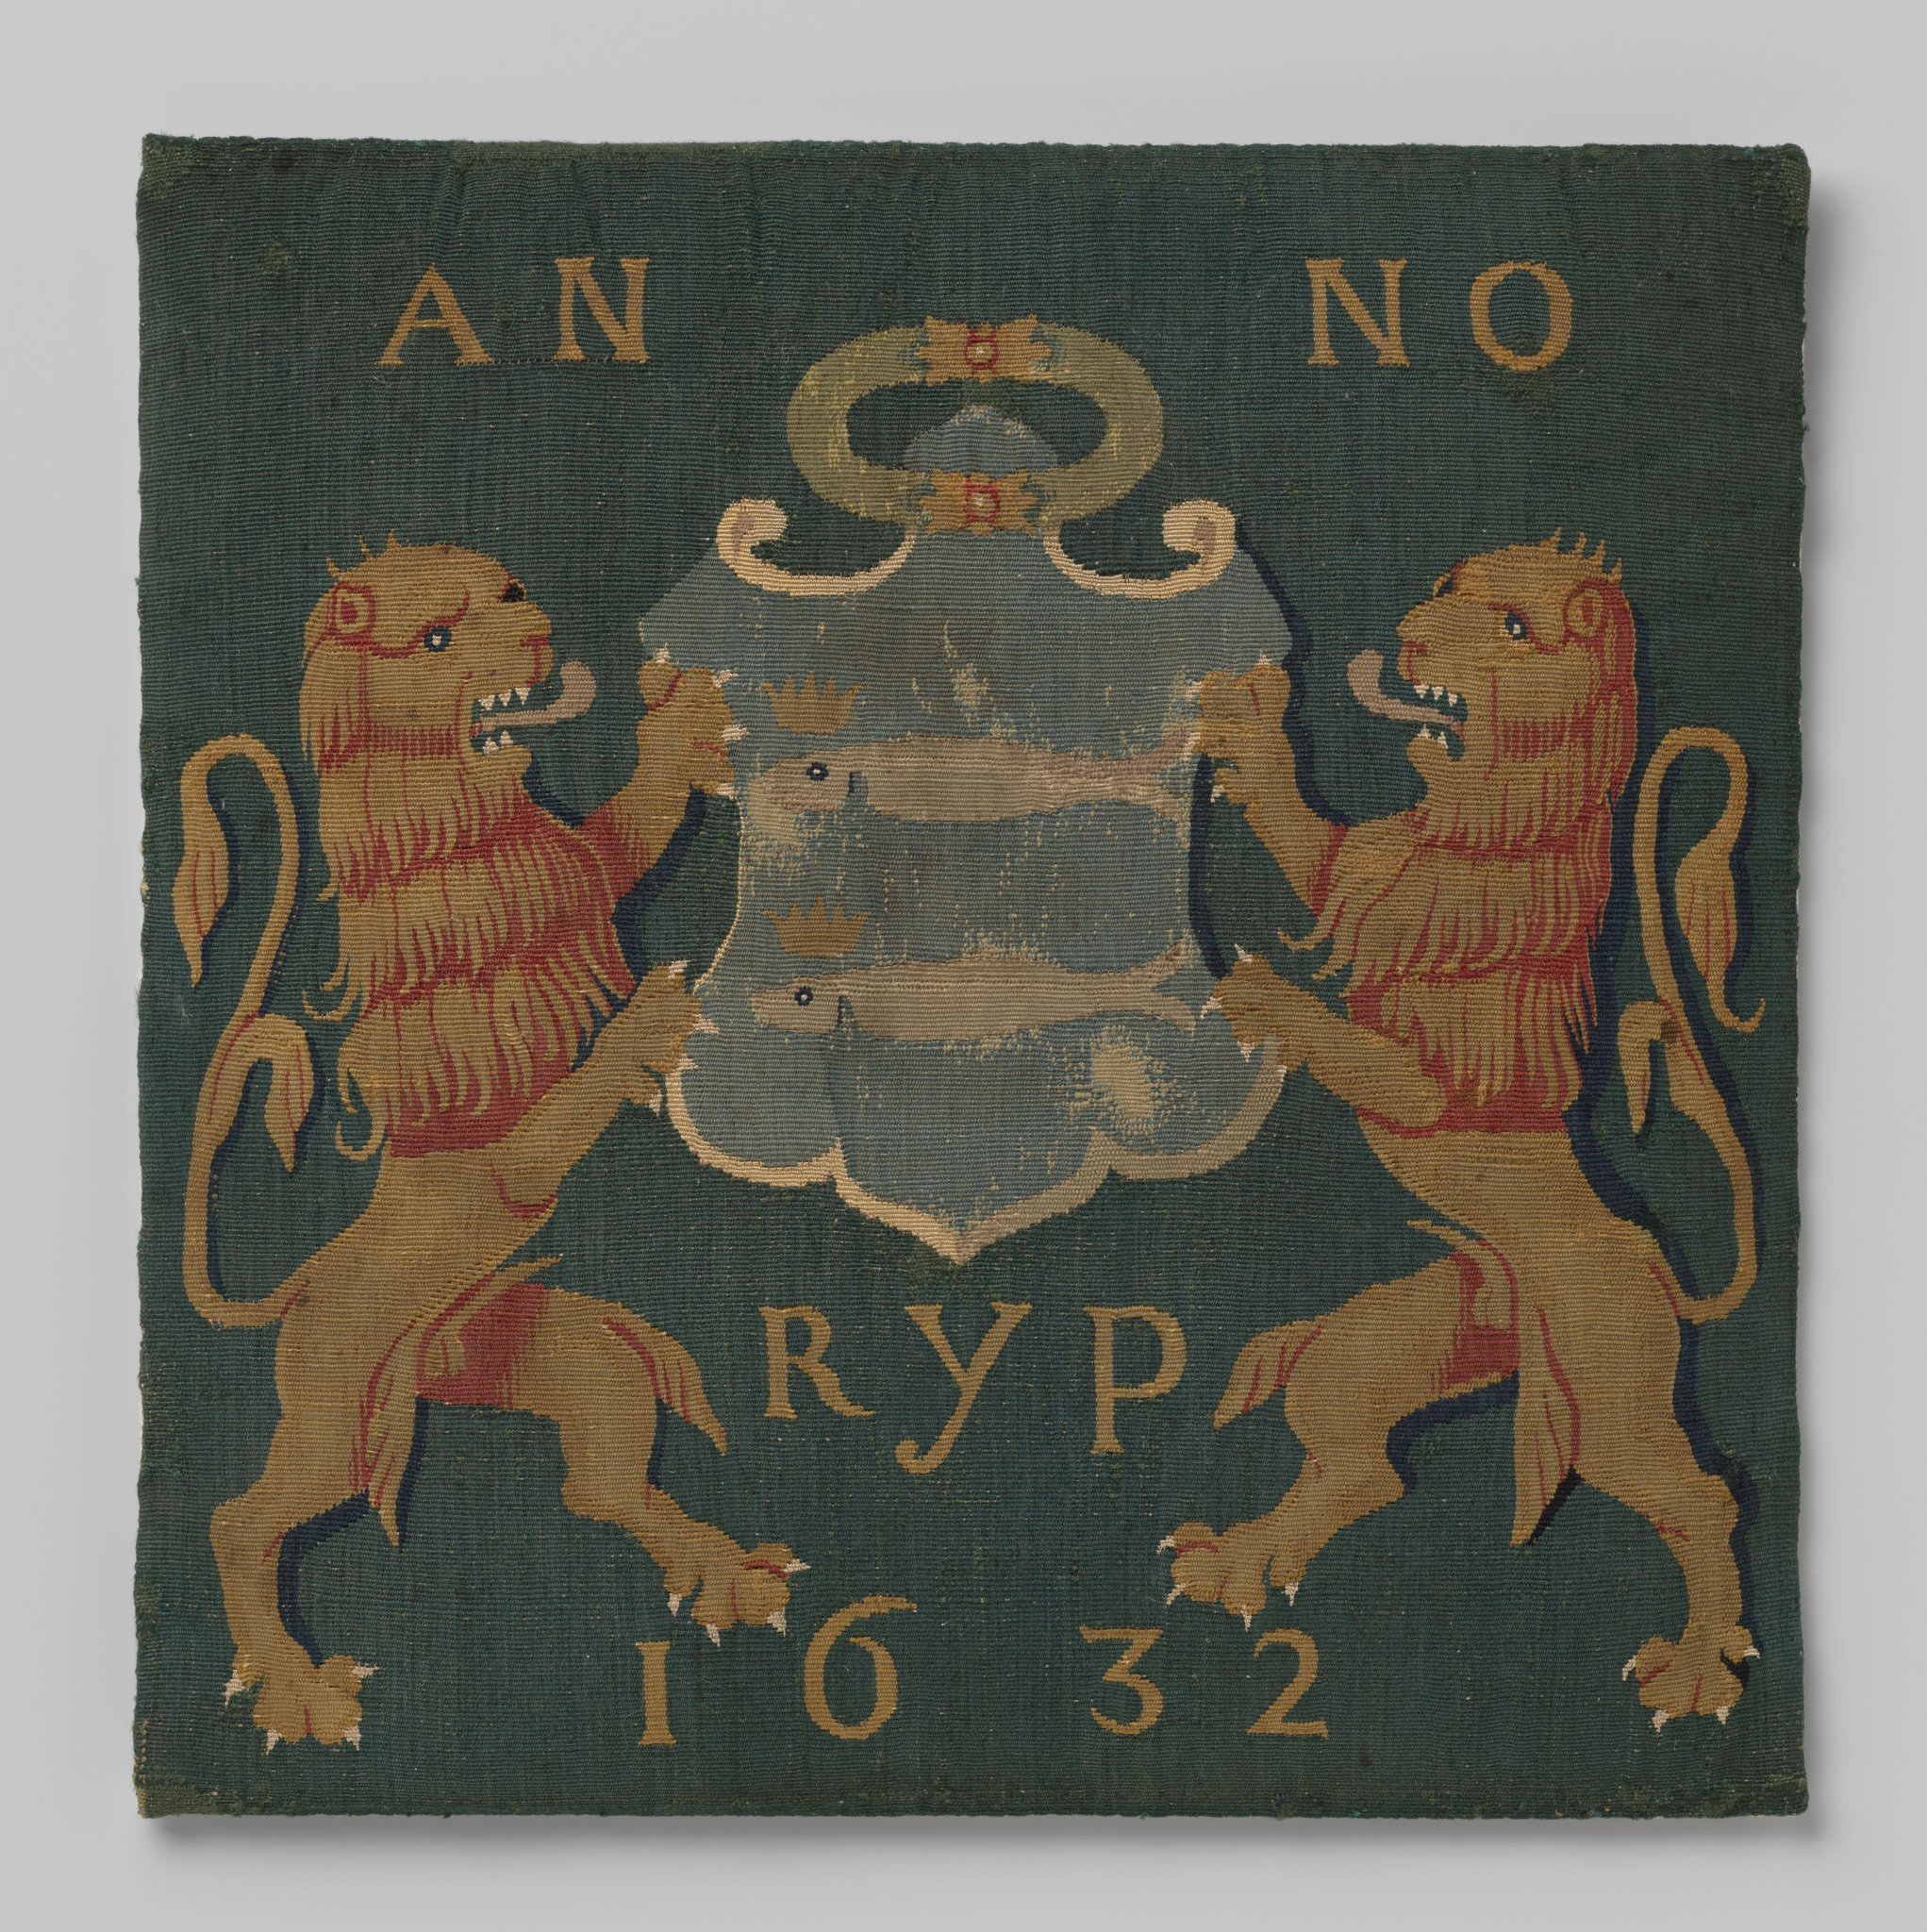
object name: kussenblad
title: Kussenblad met het gemeentewapen van De Rijp en jaartal 1632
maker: Anonymous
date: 1632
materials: silk, wool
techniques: tapestry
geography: northern netherlands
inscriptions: date: ‘AN NO // 1632’, inscription: ‘RYP’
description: Kussenblad van een magistratenkussen van tapijtweefsel met het gemeentewapen van de Rijp en als schildhouders twee leeuwen. Boven en onder het wapen de inscriptie "ANNO", "RIJP" en het jaartal 1632.